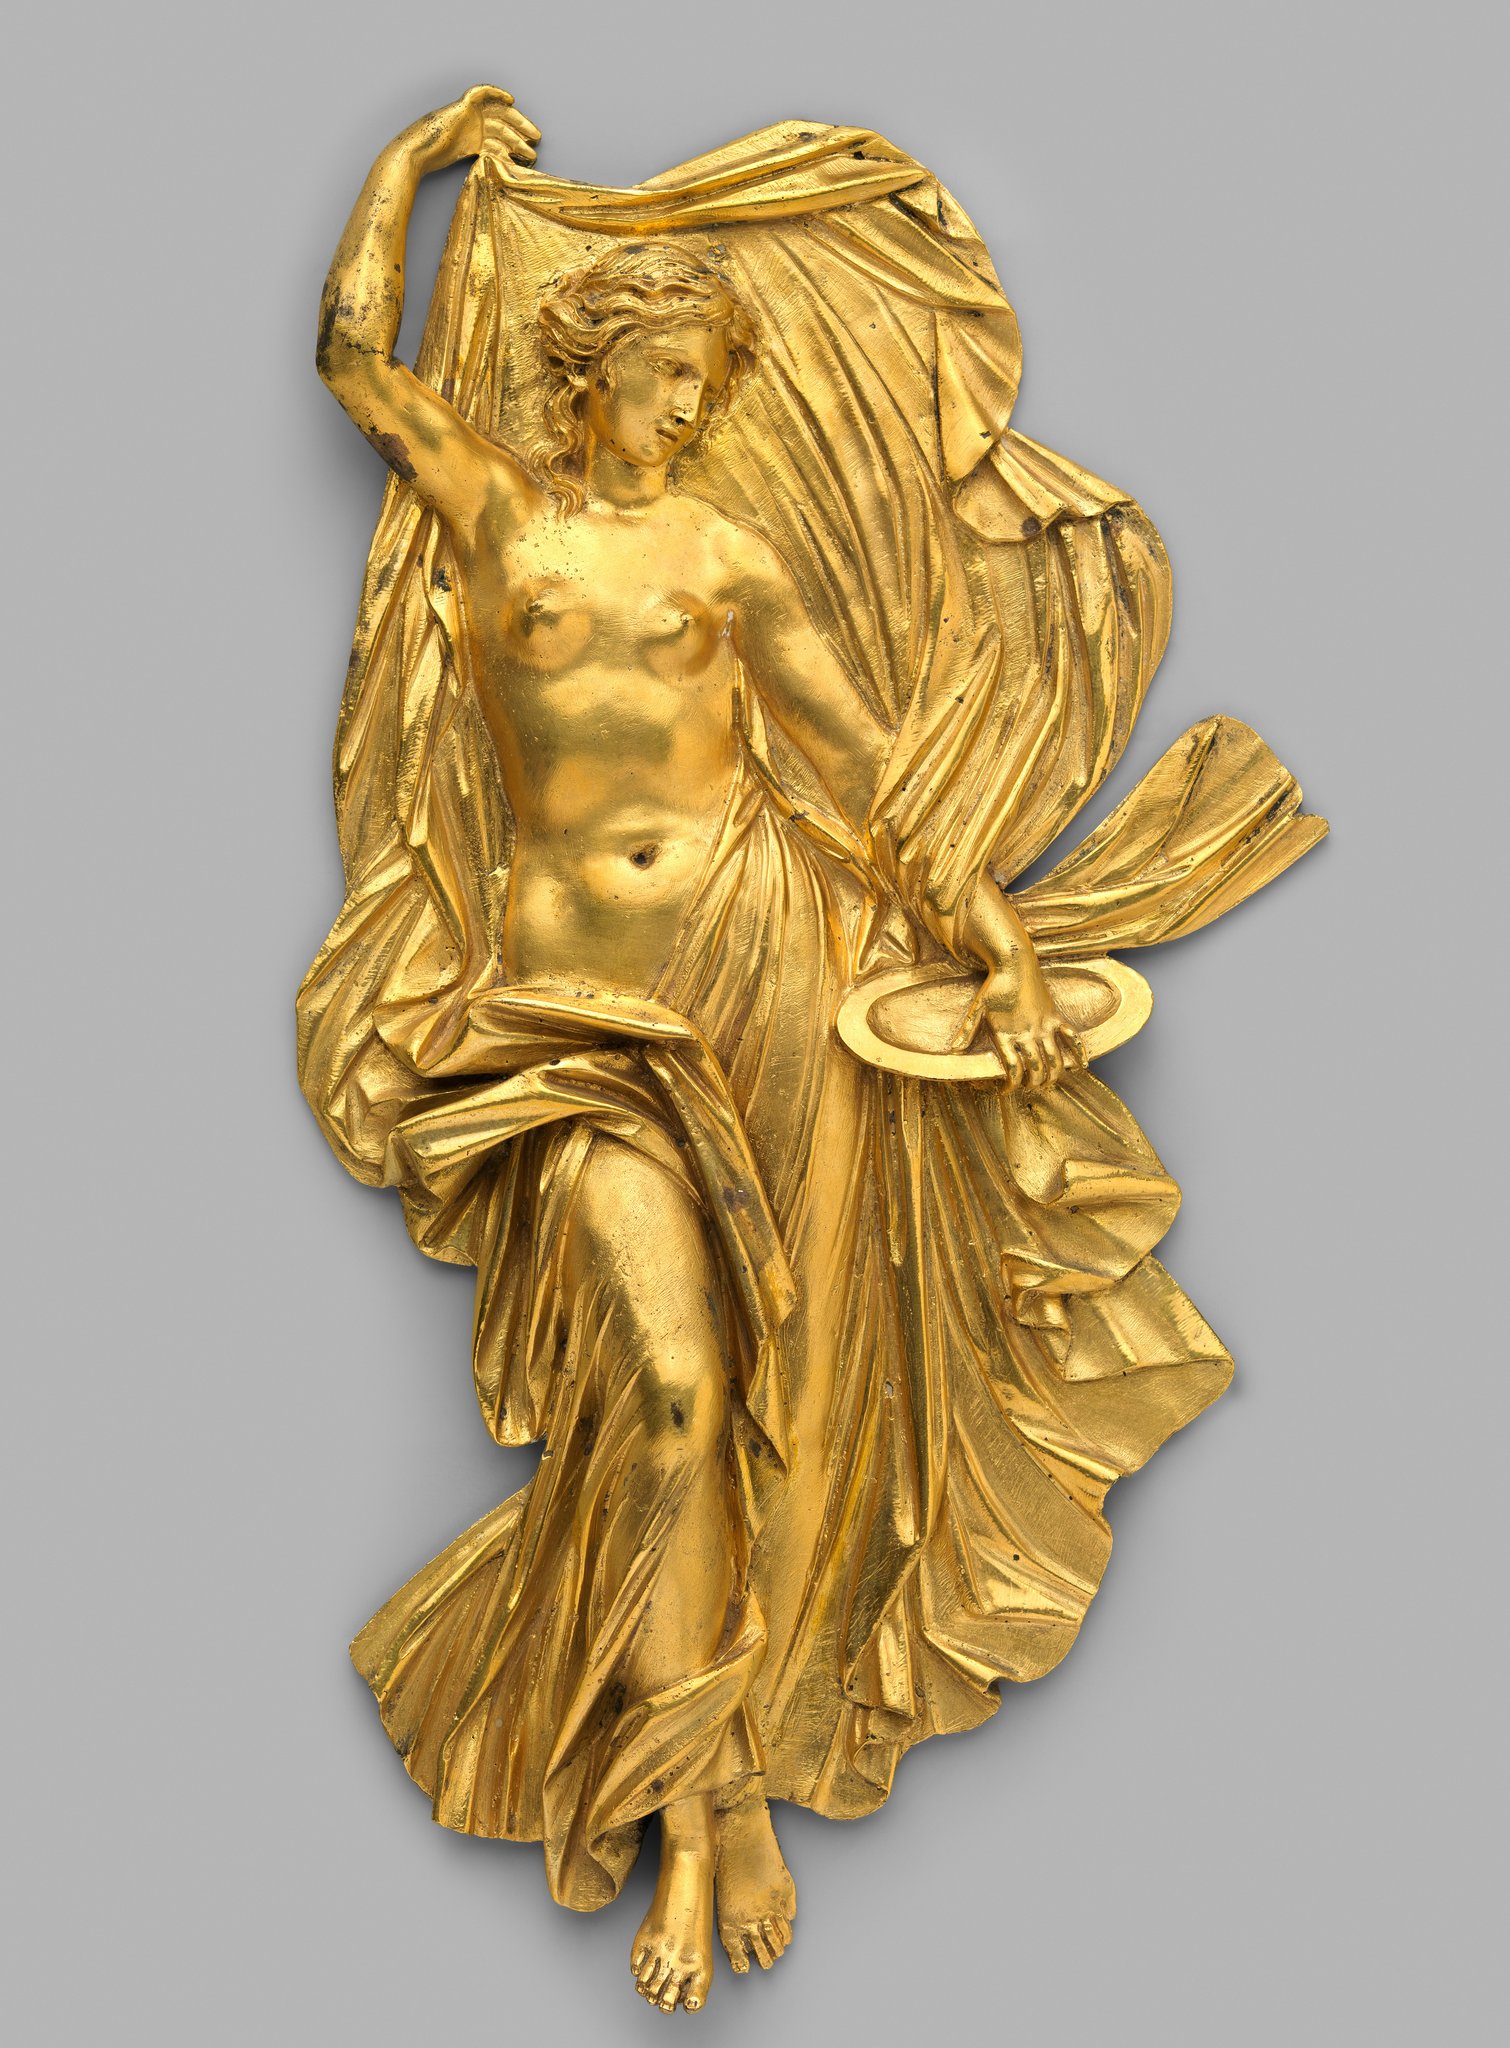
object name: figurine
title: Twelve Dancers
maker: luigi manfredini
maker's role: maker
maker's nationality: italian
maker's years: 1771-1840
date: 1767-1833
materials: gilt bronze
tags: female nudes,dancers